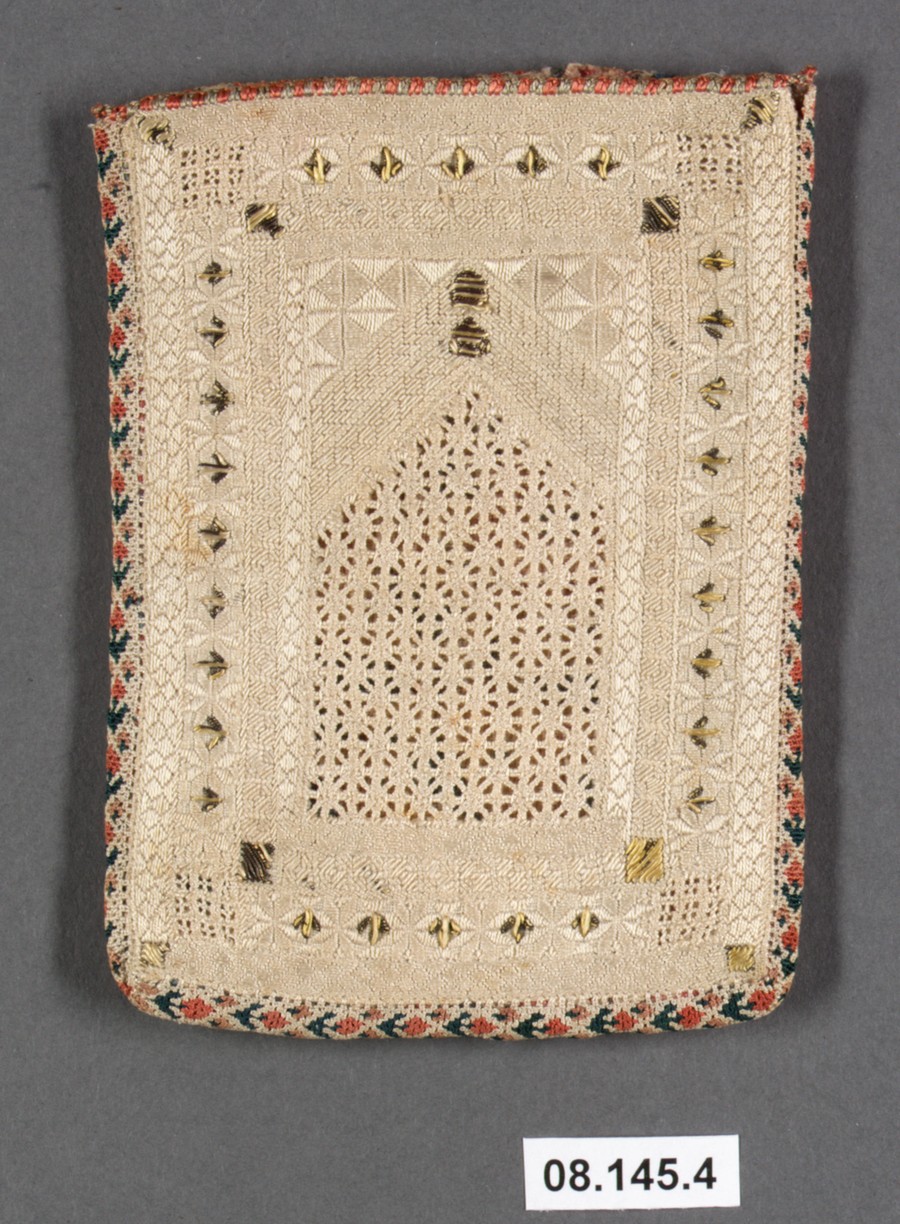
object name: bag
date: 1701-1800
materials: linen, metal thread, silk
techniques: embroidery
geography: iran